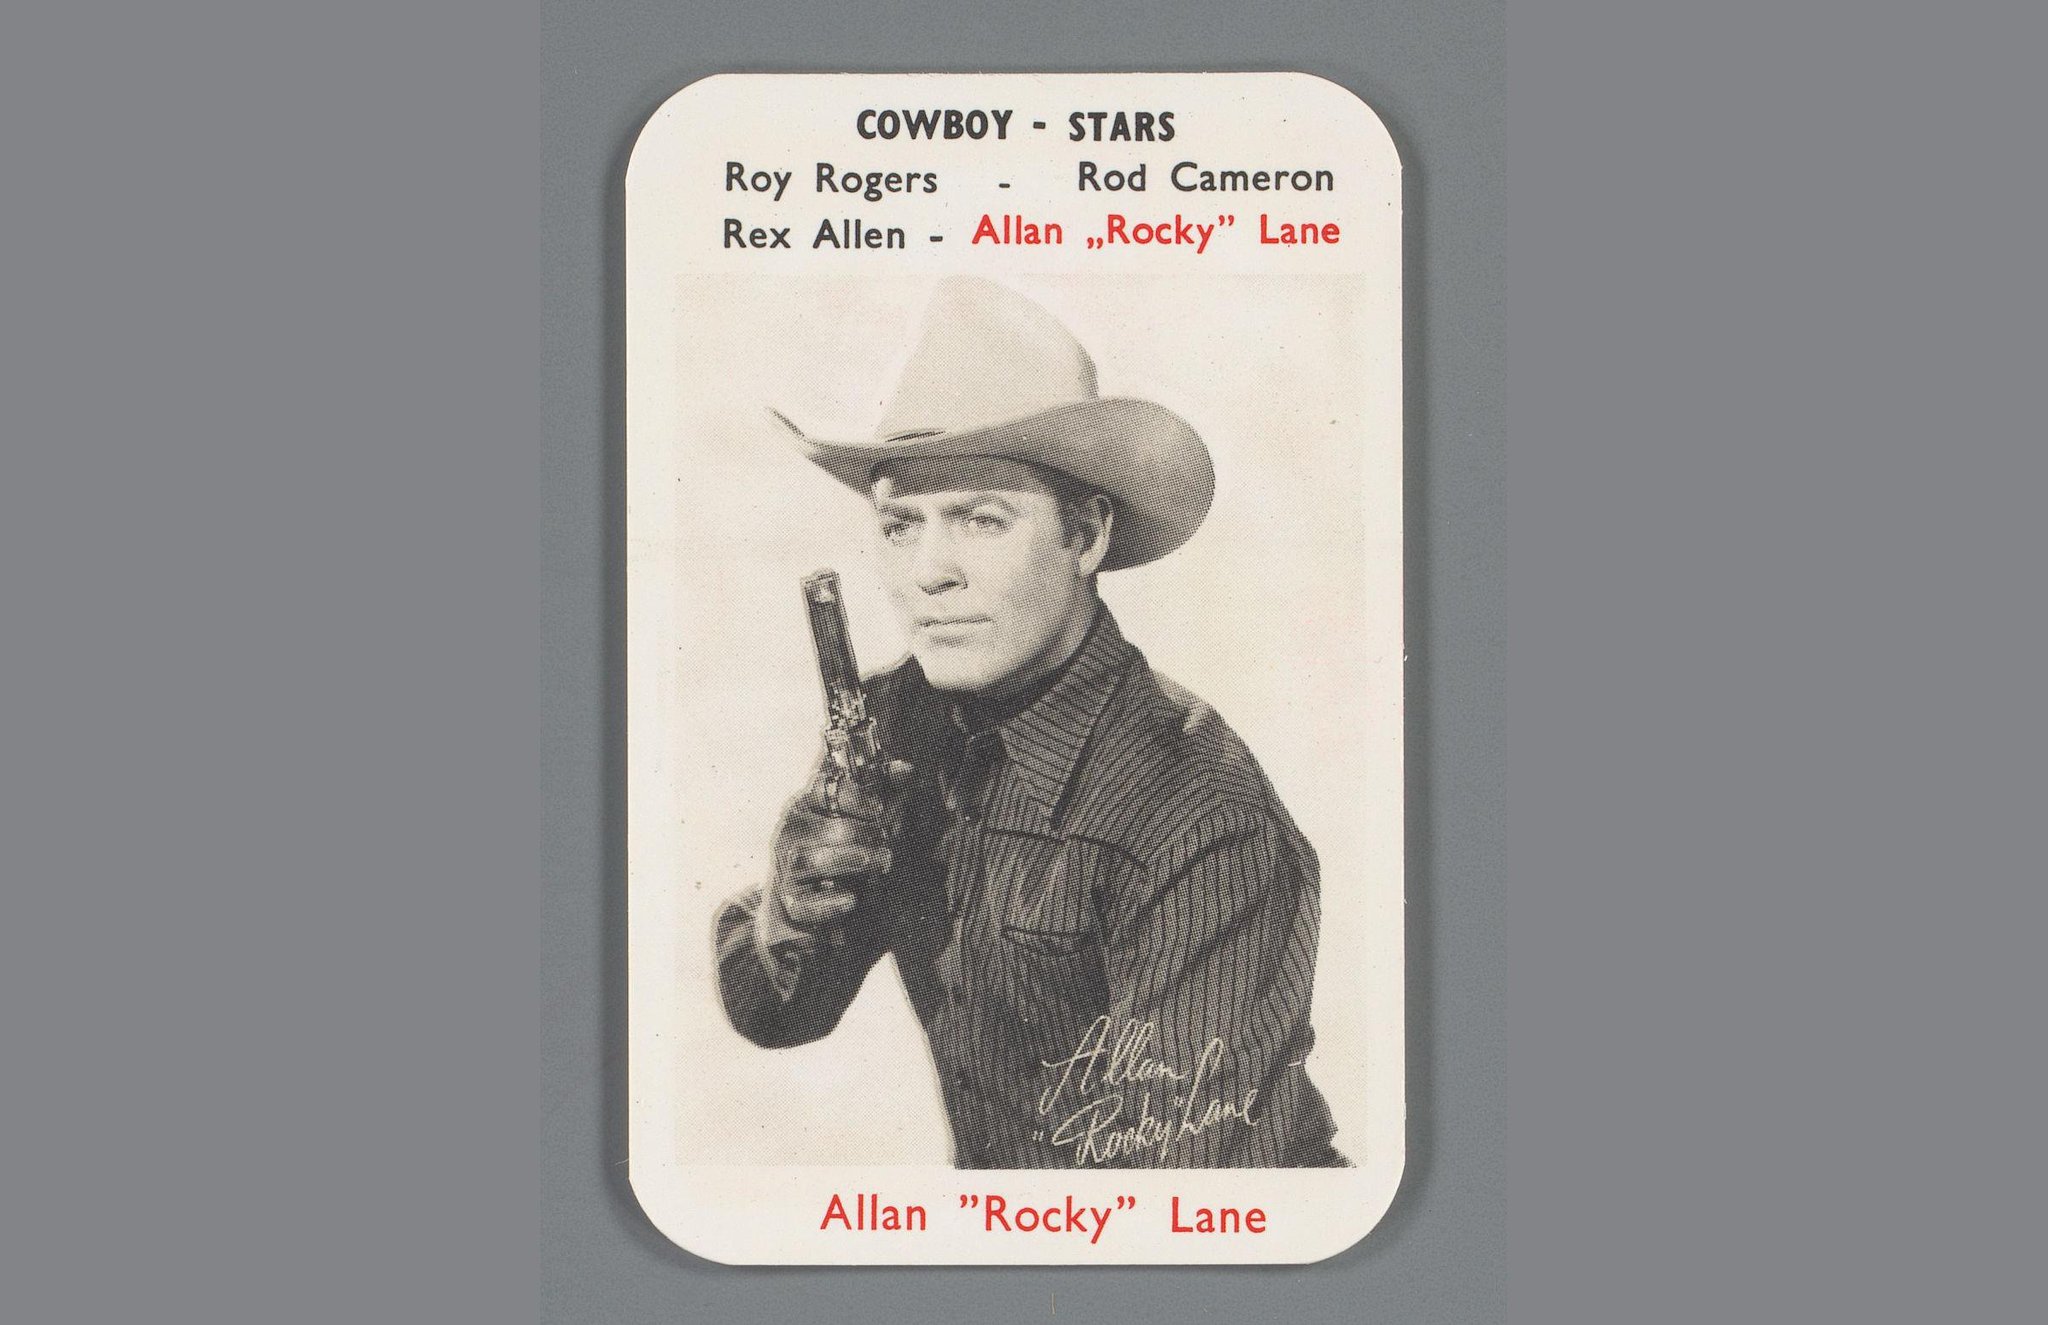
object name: playing card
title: Allen "Rocky" Lane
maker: Anonymous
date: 1960-1970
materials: paper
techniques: autotype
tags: portrait of actor, actress